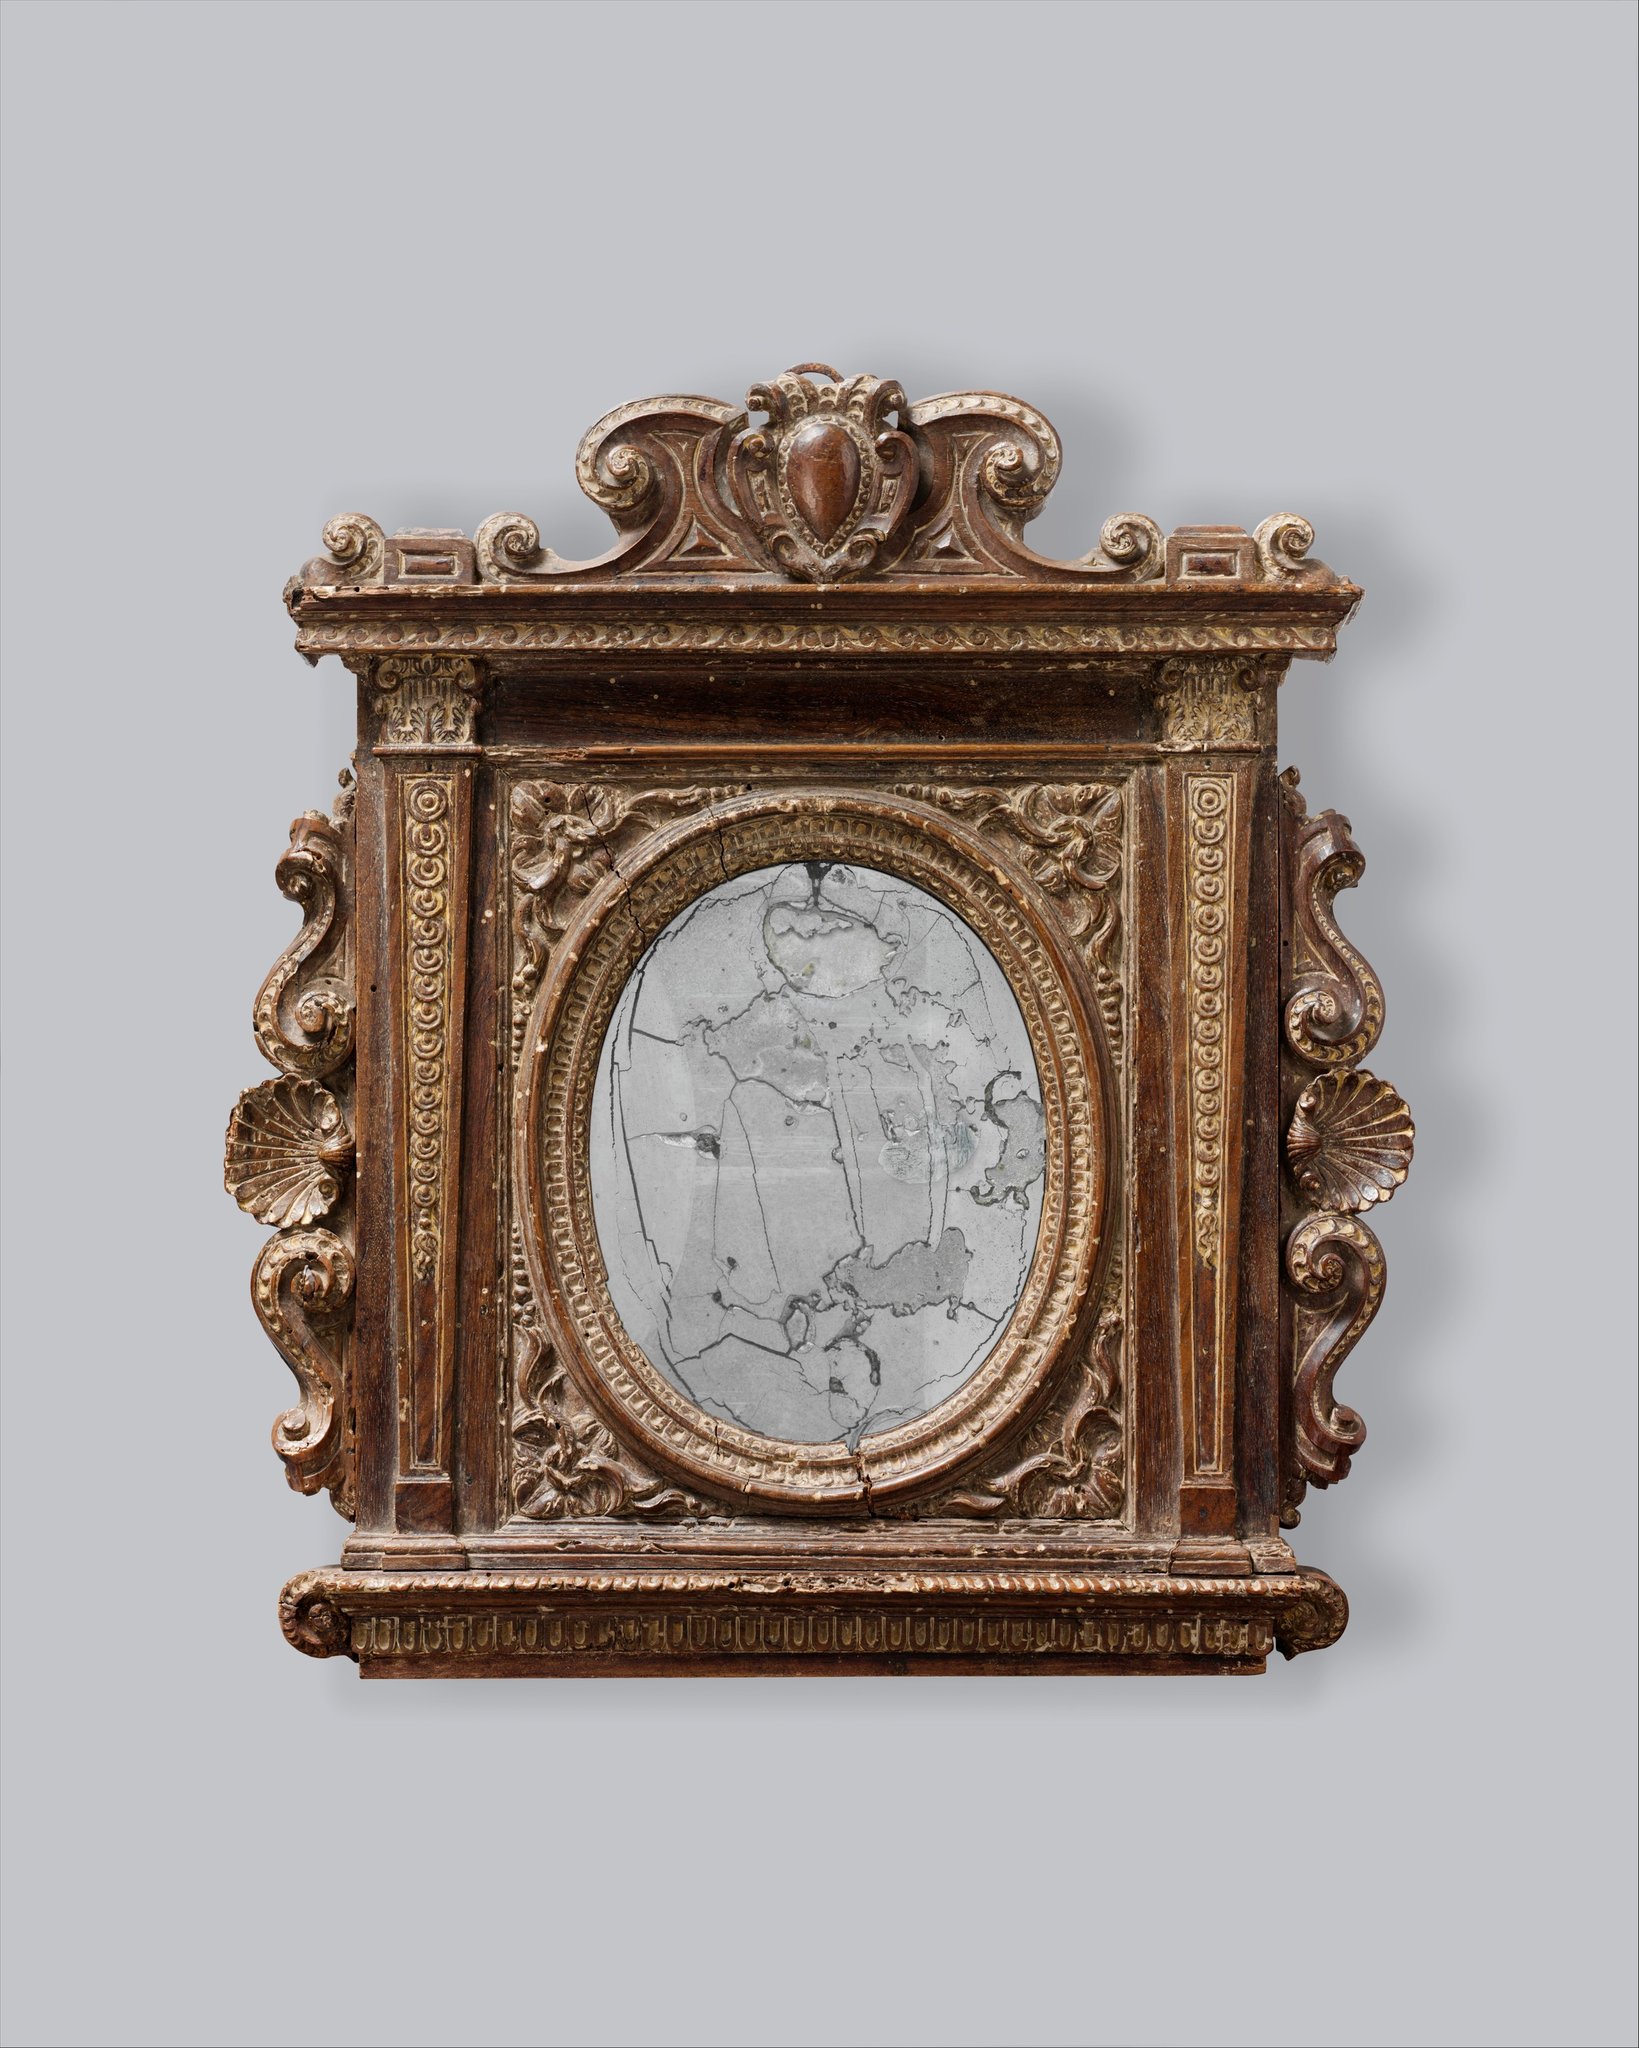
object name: frame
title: Tabernacle mirror frame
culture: italian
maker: Anonymous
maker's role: artist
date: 1540-1560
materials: wood